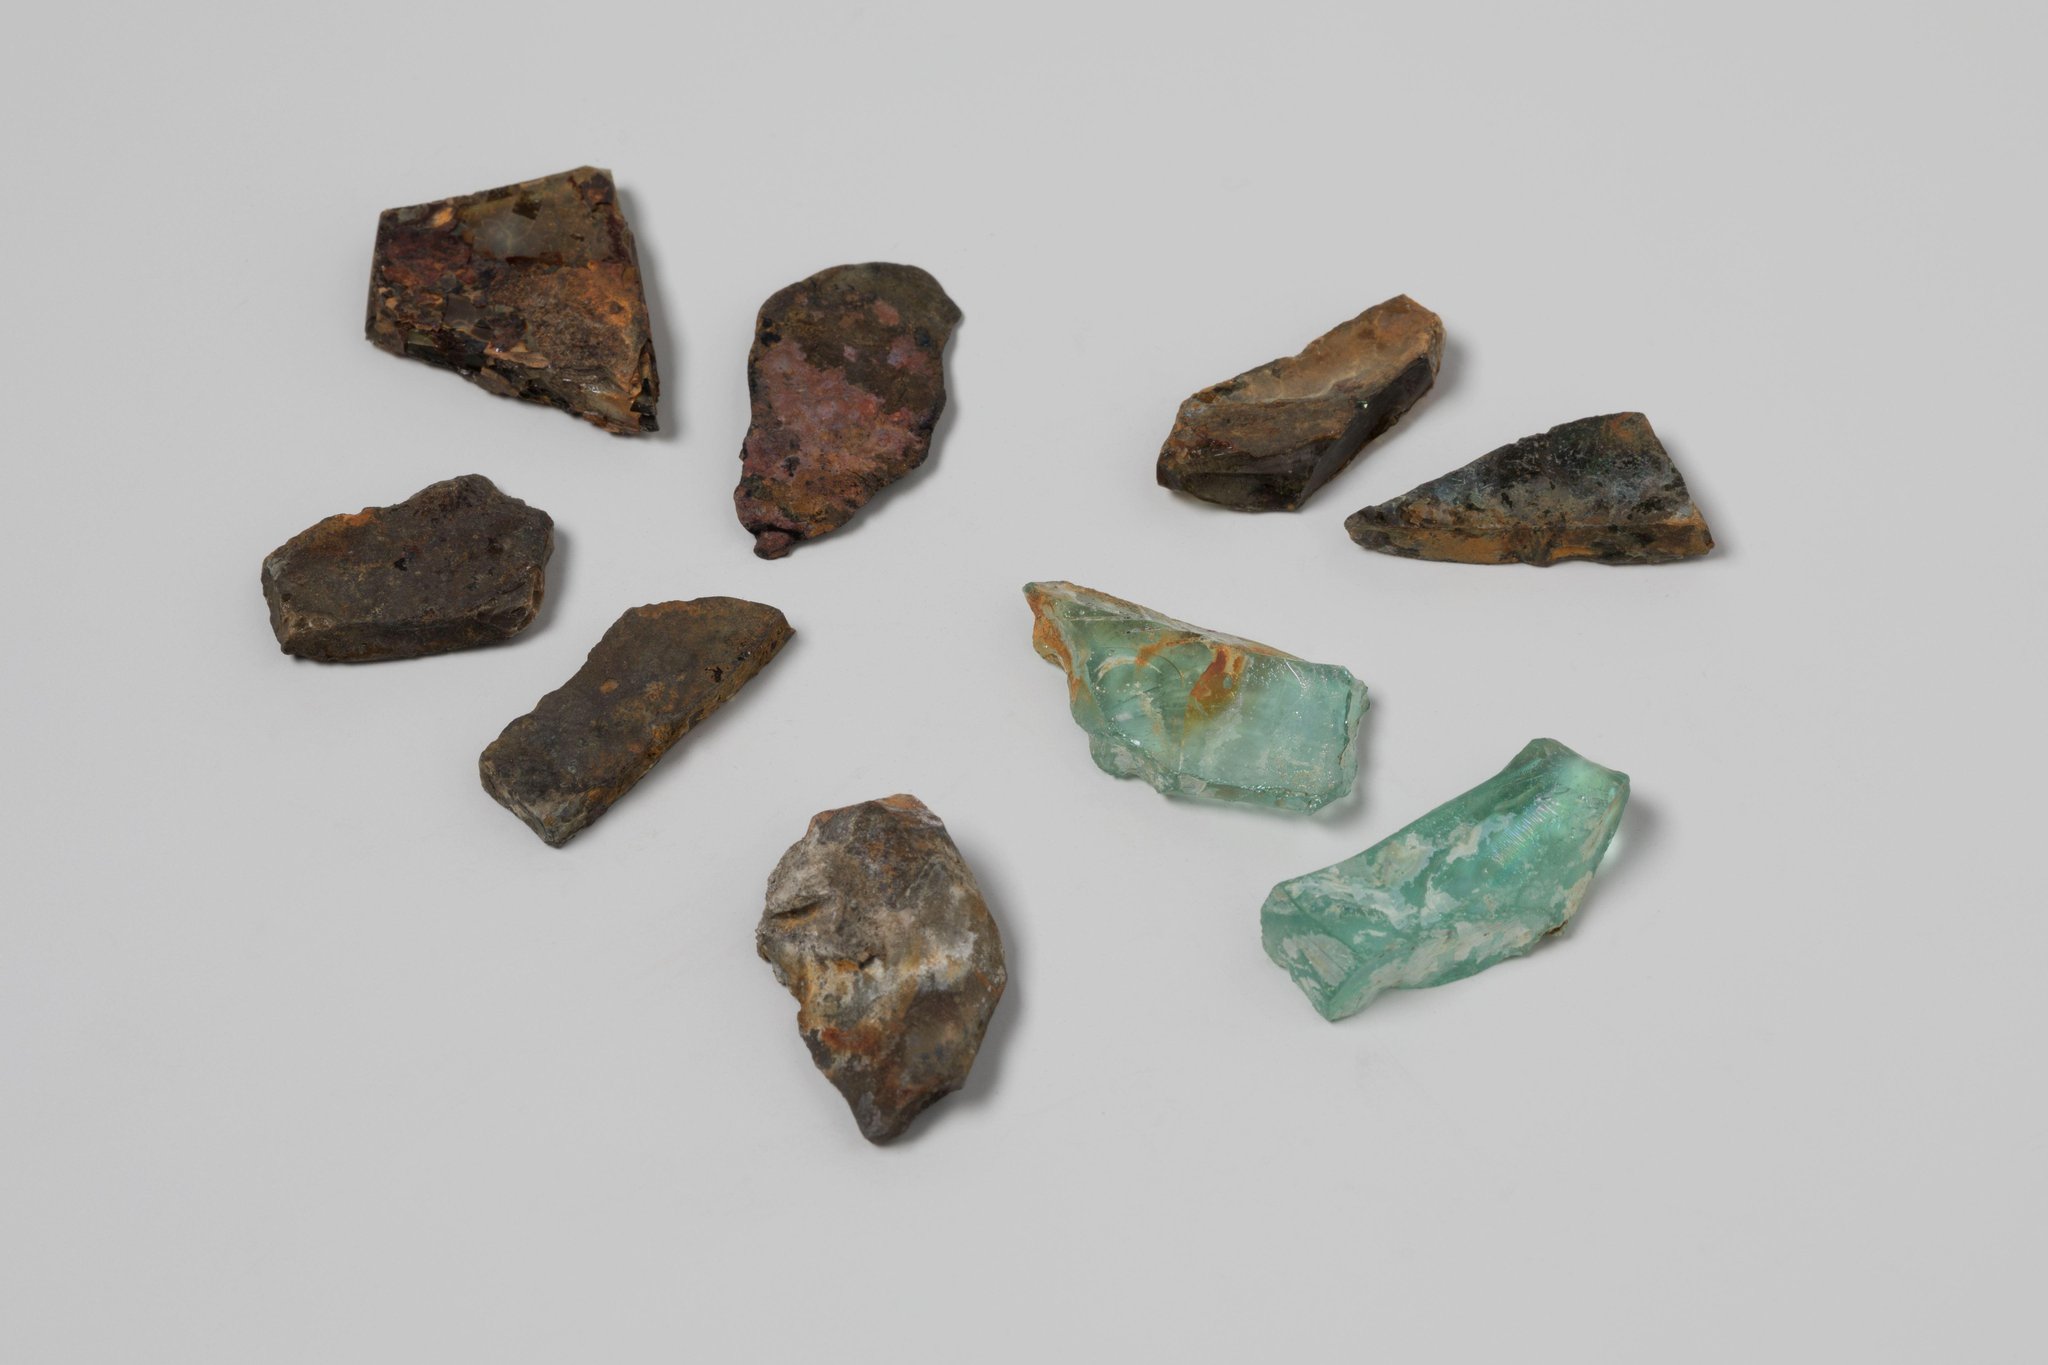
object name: wine bottle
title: Scherven van wijnflesens en een kelderfles uit het wrak van de in 1735 vergane Oost-Indiëvaarder 't Vliegend Hart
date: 1700-1735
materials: glass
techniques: manufacturing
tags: 't vliegend hart (schip), verenigde oostindische compagnie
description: Zeven zwaar aangetaste glasscherven van een wijnfles en twee helder groene scherven van mogelijk een kelderfles.